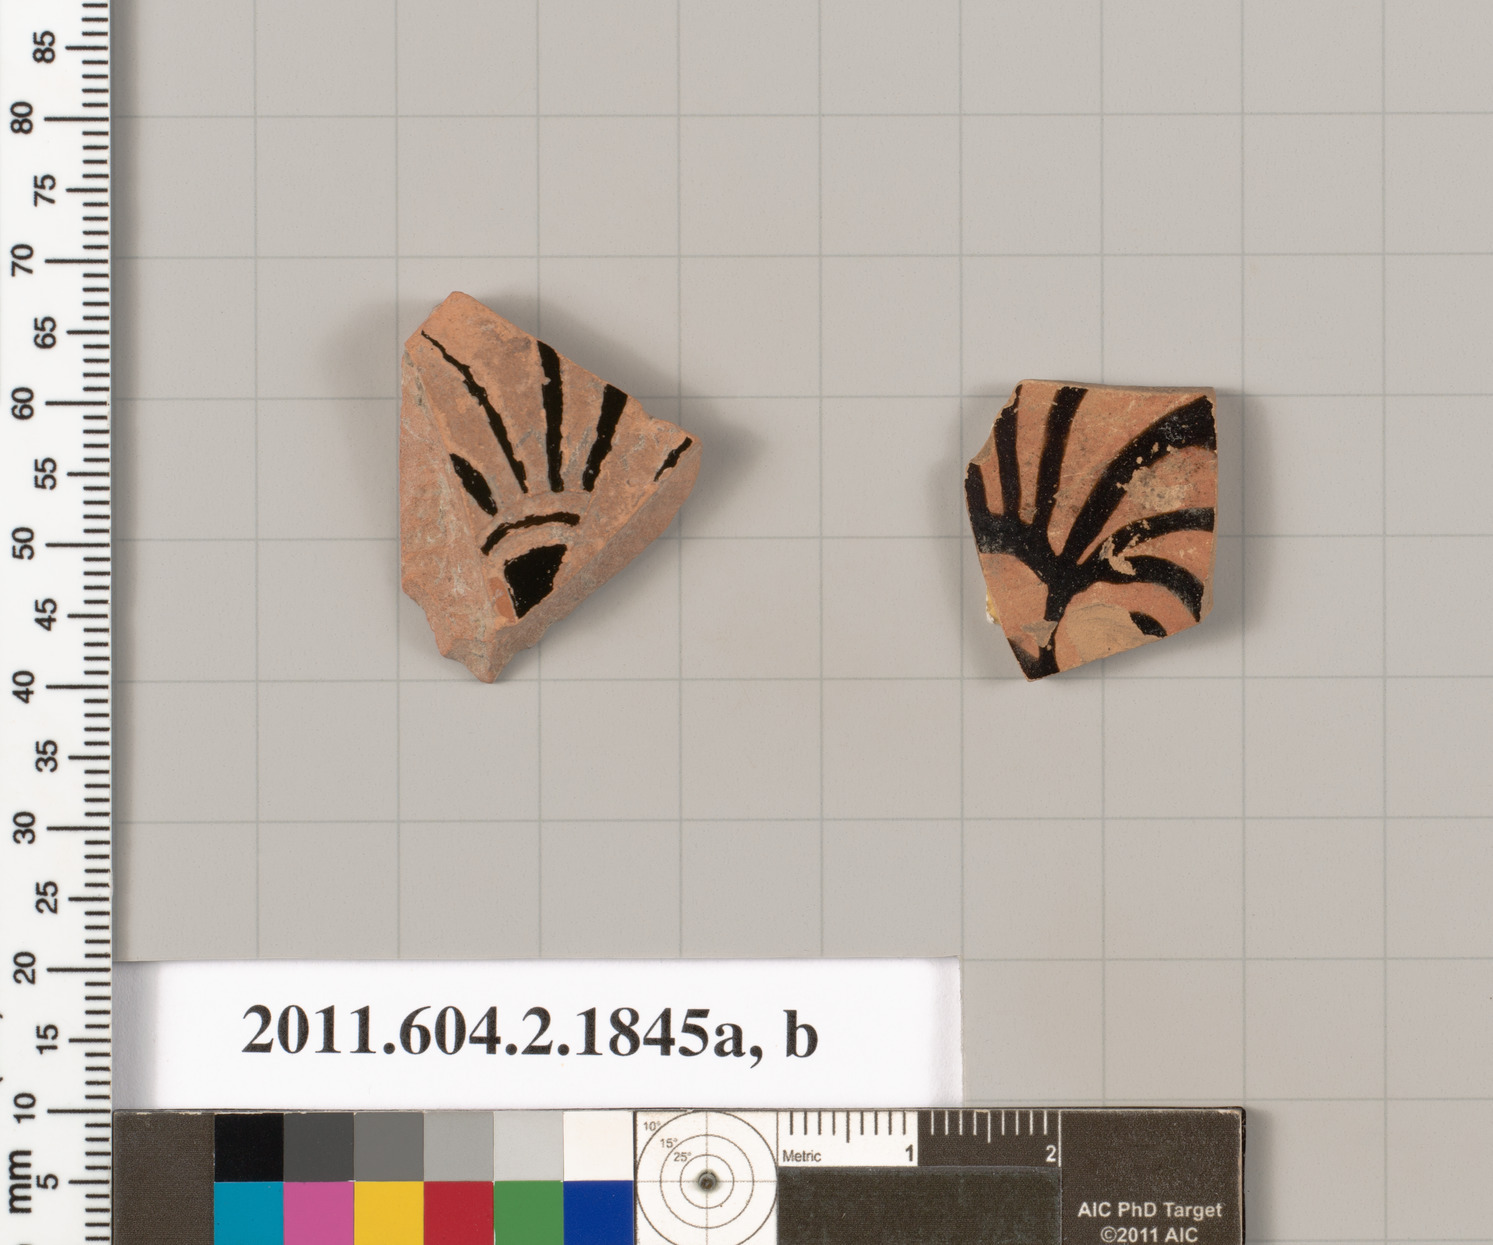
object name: skyphos fragment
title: Terracotta fragments of skyphoi (deep drinking cups)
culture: greek, attic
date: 450-426 BCE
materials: terracotta